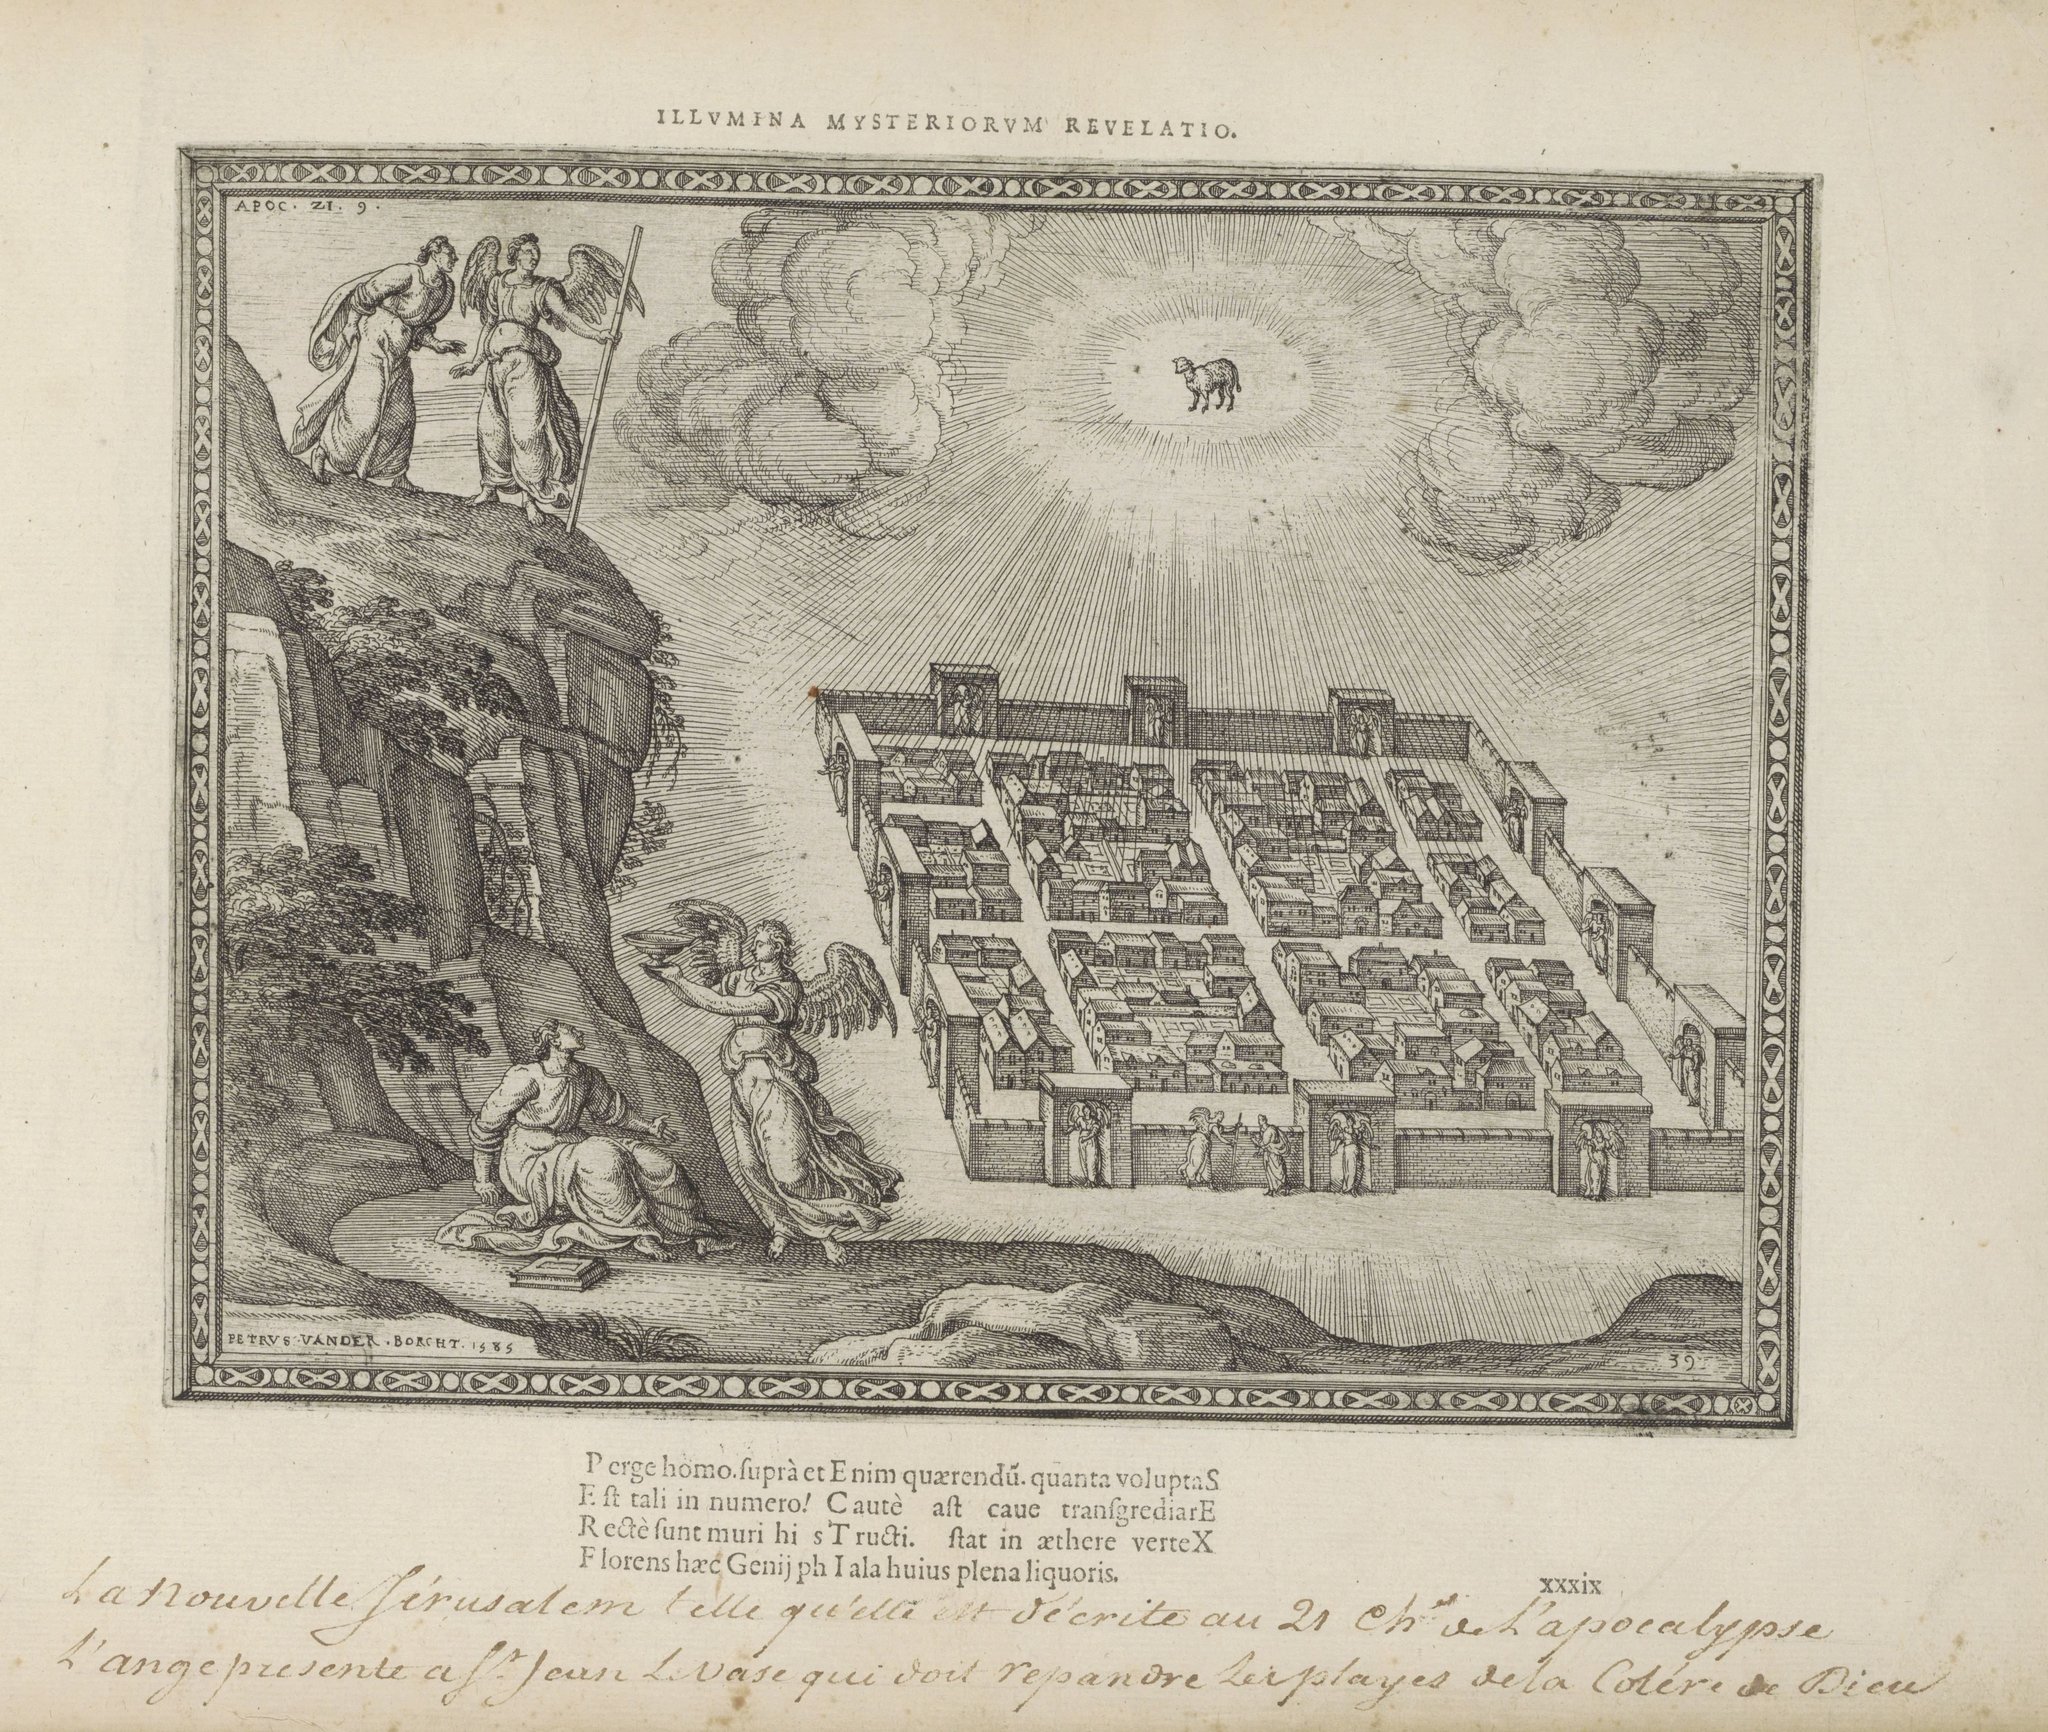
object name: album leaf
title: Emblemata Sacra è praecipuis utriusque testamenti historiis concinnata (Nieuwe Testament)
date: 1585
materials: paper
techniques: etching, letterpress printing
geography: antwerp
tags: the new jerusalem, an angel shows john the new (heavenly) jerusalem coming down from heaven; sometimes christ is shown leading his lambs to the city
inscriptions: inscription: ‘La nouvelle Jérusalem telle qu'elle est décrits au 21 ch' de l'apocalypse/ L'ange presente St. Jean le vase qui doit repandre les playes de la Colére de Dieu’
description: Een Engel komt op Johannes af, neemt hem mee naar een hoge berg en toont hem het nieuwe Jeruzalem, neerdalend uit de hemel. Boven de stad een lam. Elk van de twaalf poorten van de stad wordt bewaakt door een engel (Op. 21). Met een motto in het Latijn boven de voorstelling en een vierregelig onderschrift in het Latijn onder de prent. De prent maakt deel uit van een album.